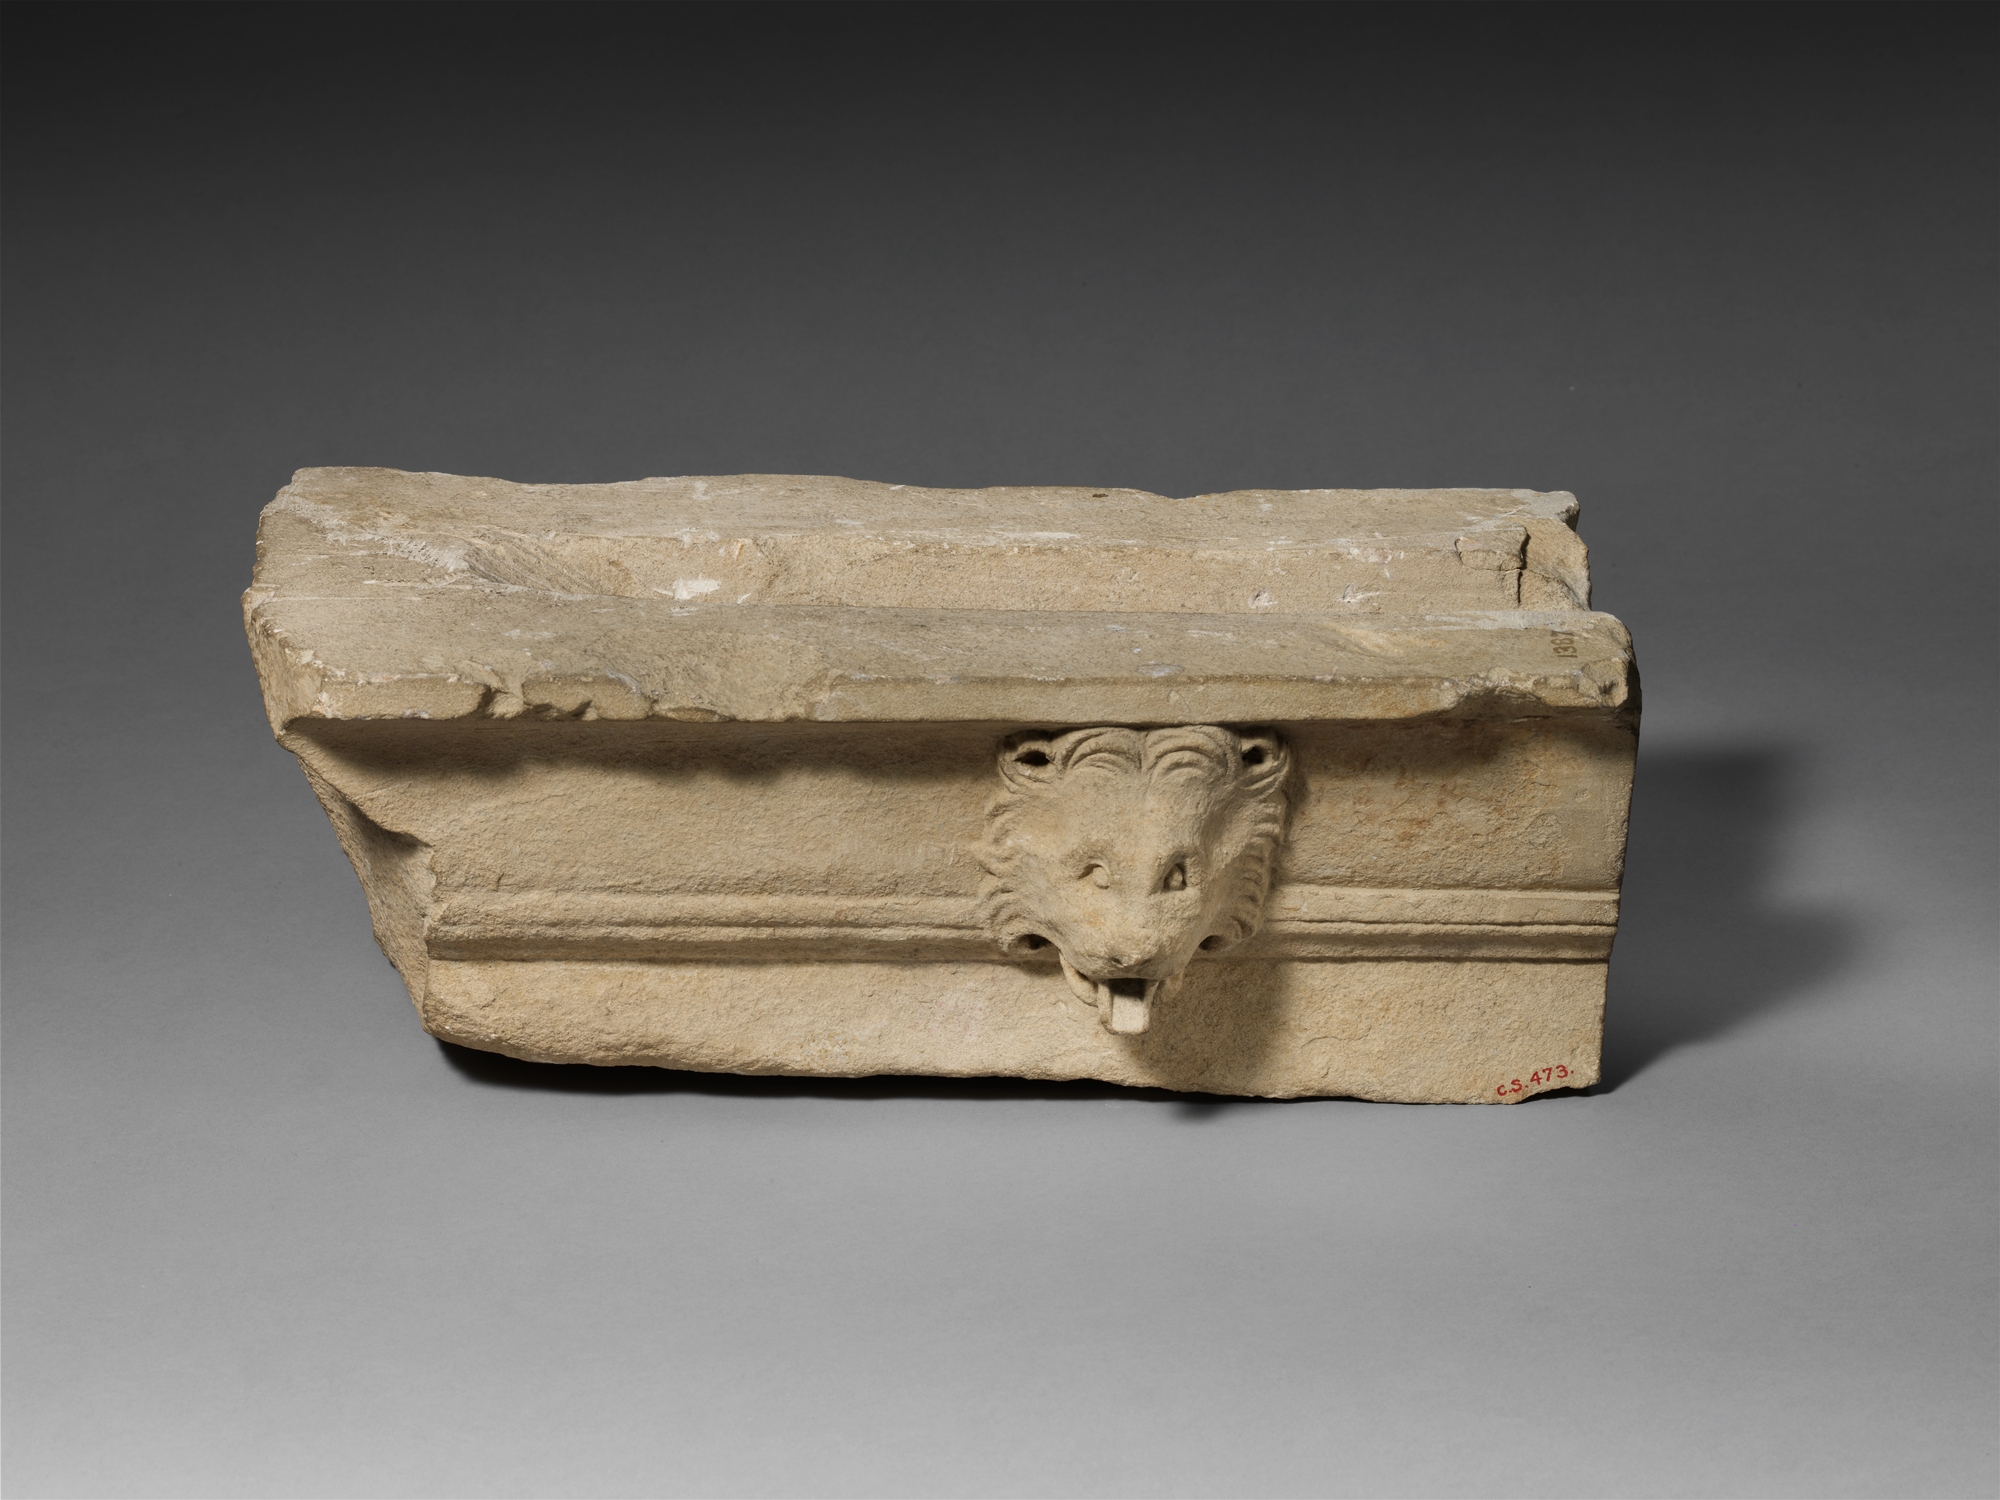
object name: capital cornice with lion head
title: Limestone cornice with a lion’s head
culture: cypriot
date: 1-100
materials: limestone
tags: lions